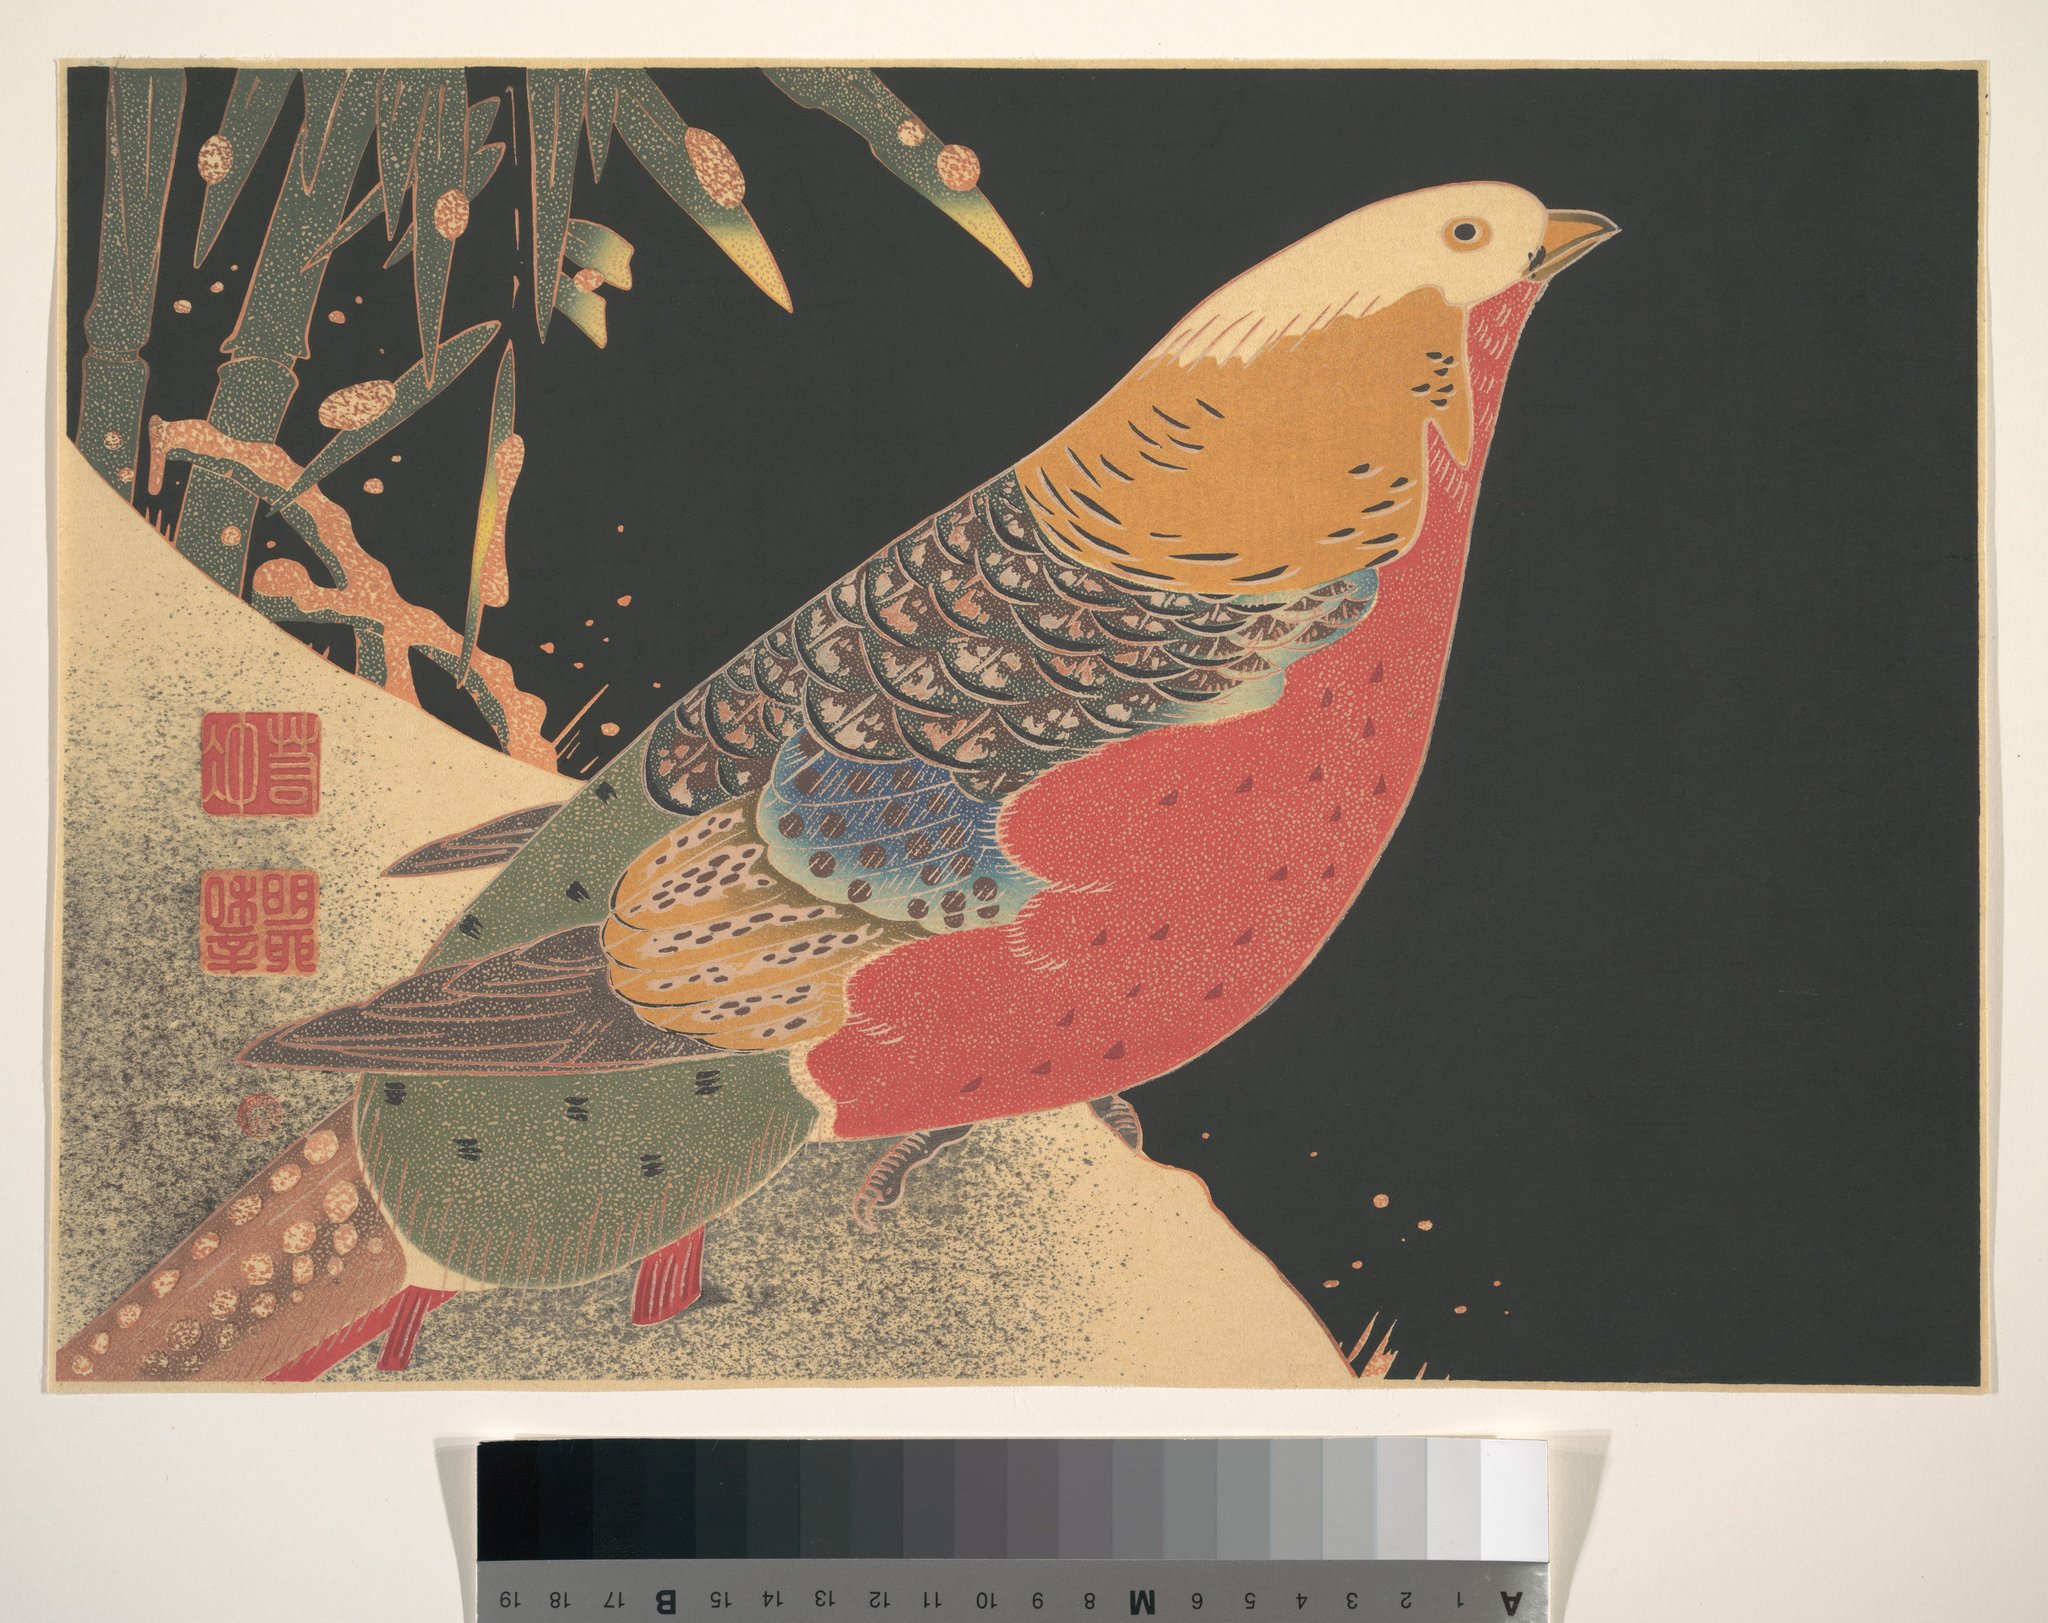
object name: reproduction of a print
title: Golden Pheasant in the Snow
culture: japanese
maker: itō jakuchū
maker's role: artist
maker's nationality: japanese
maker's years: 1716-1800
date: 1900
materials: ink, paper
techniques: woodblock print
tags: pheasants,leaves,snow